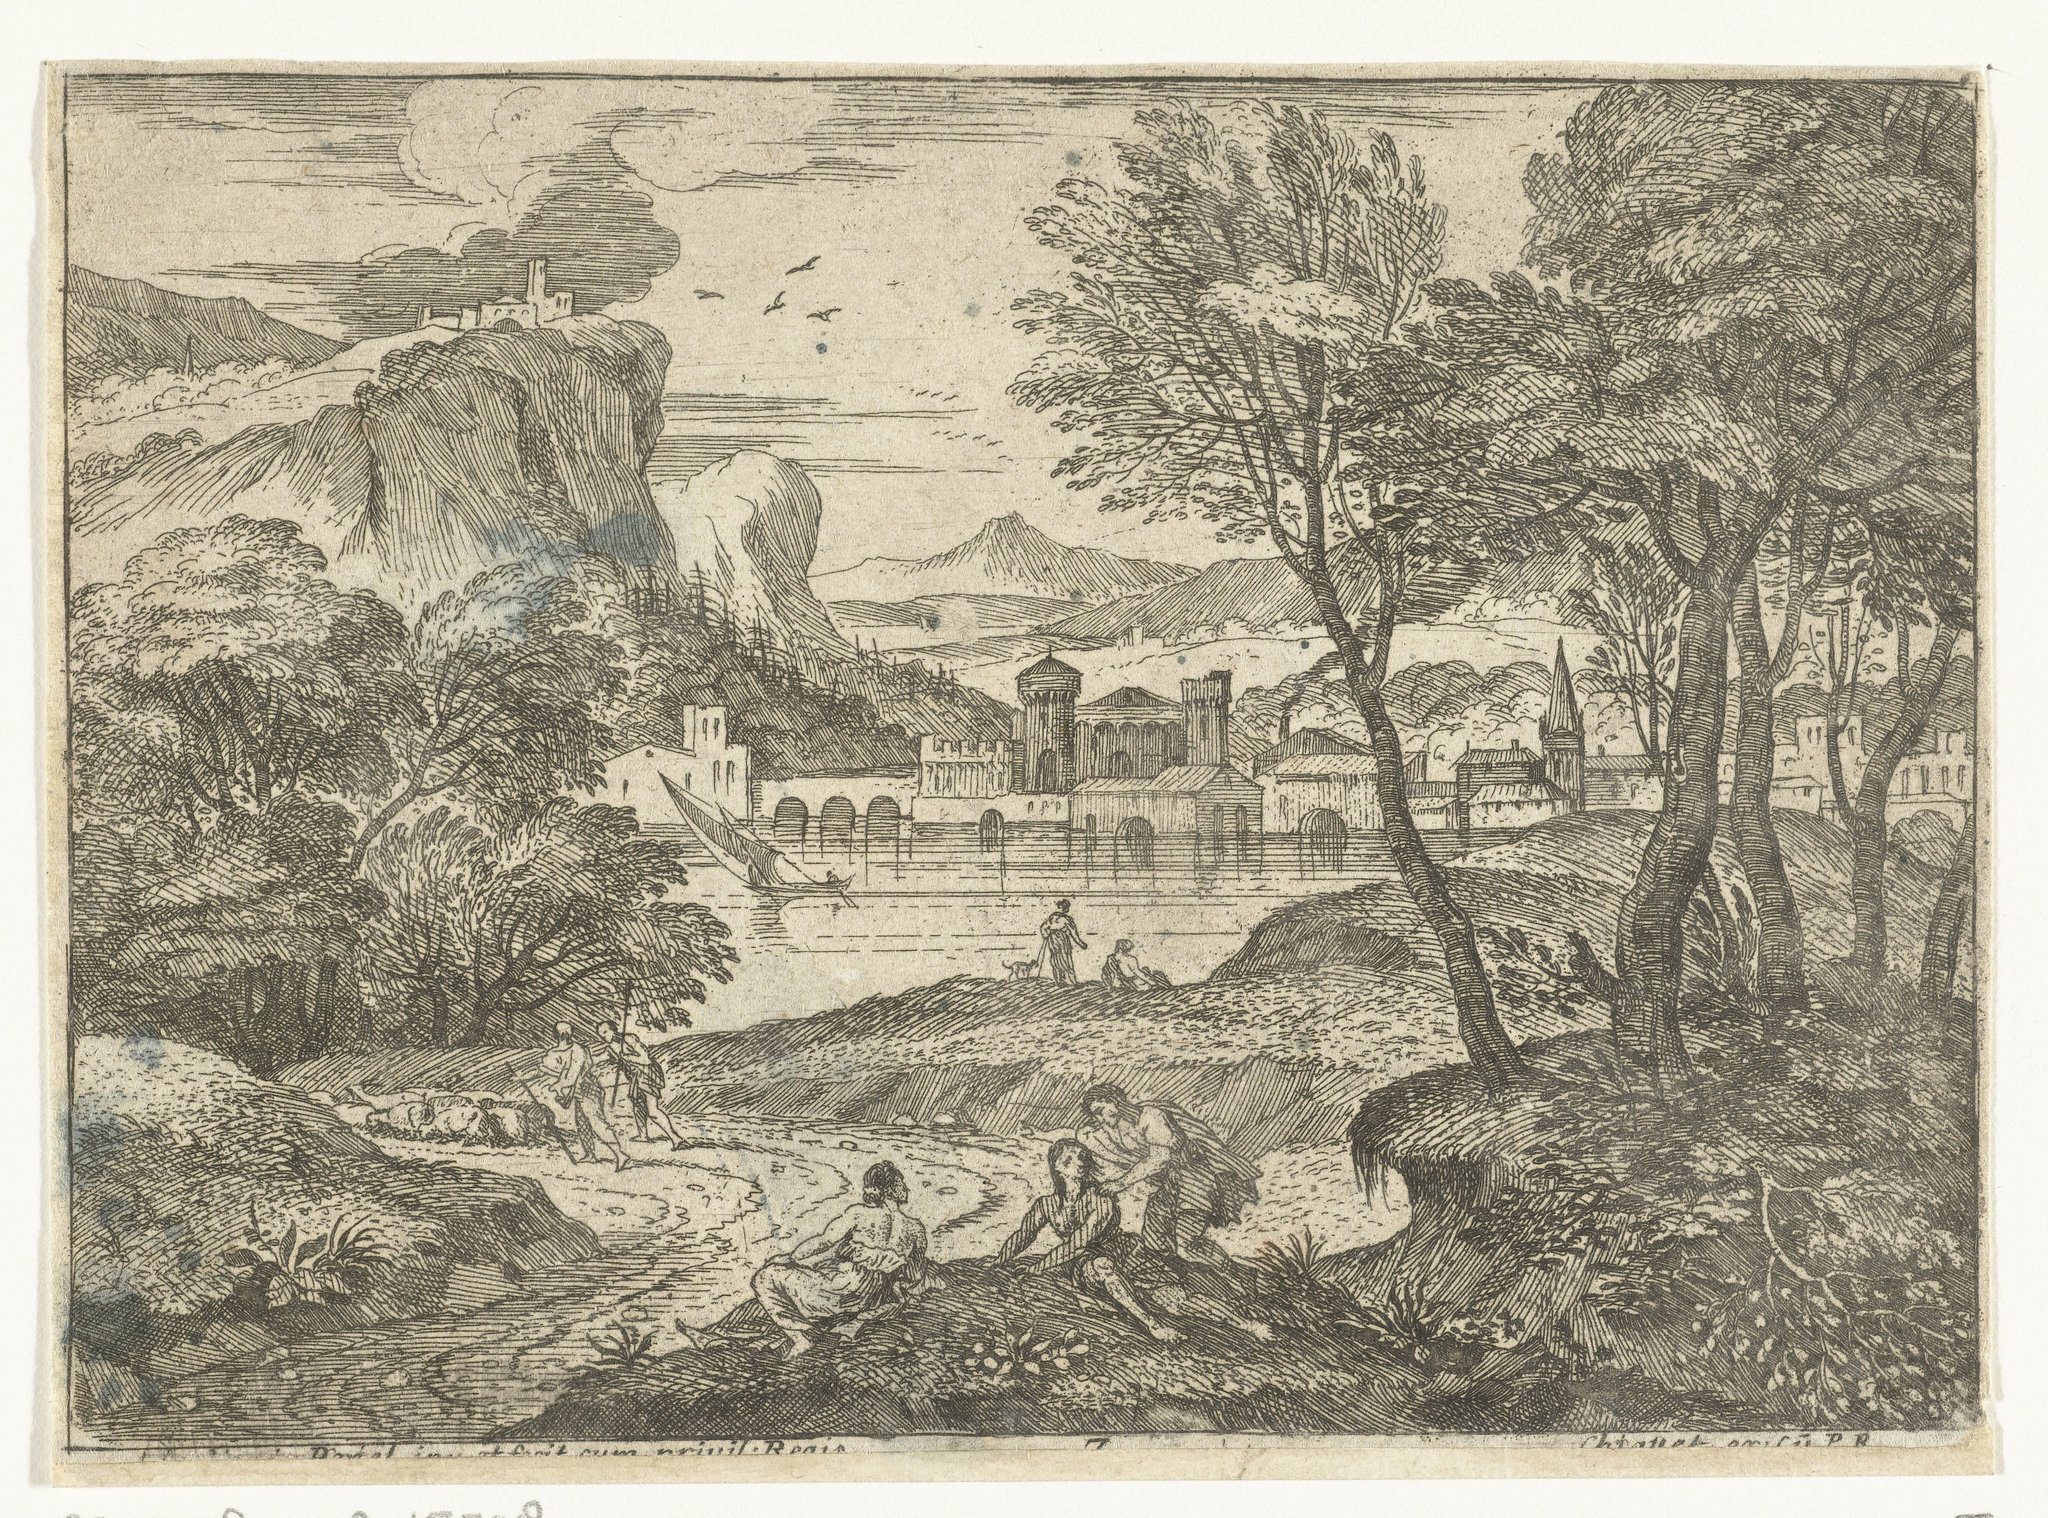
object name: print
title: Landschappen, serie acht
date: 1648-1705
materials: paper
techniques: etching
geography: france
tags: landscapes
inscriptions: collector's mark: Lugt 2228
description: Landschap met op de voorgrond een staande en twee zittende figuren langs een slingerend pad; verderop twee wandelaars. Op de achtergrond een stad aan een meer en een gezicht op een bergdorp linksboven. Eerste prent uit de serie van vier.